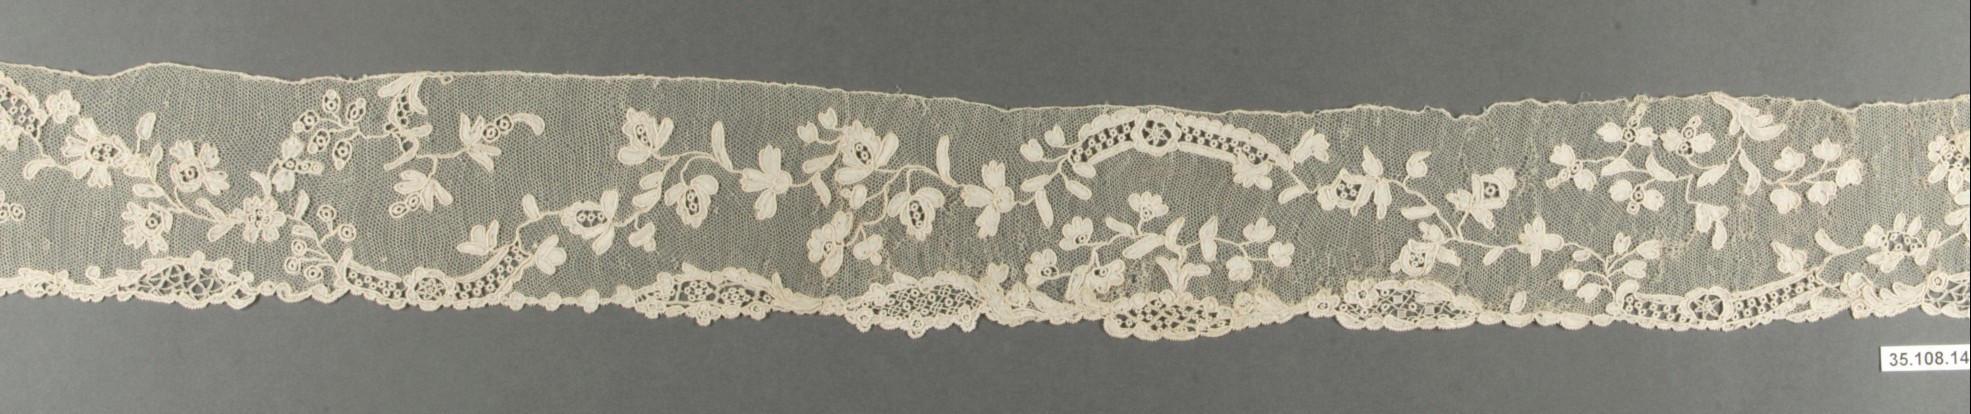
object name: border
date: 1701-1800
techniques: lace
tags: flowers